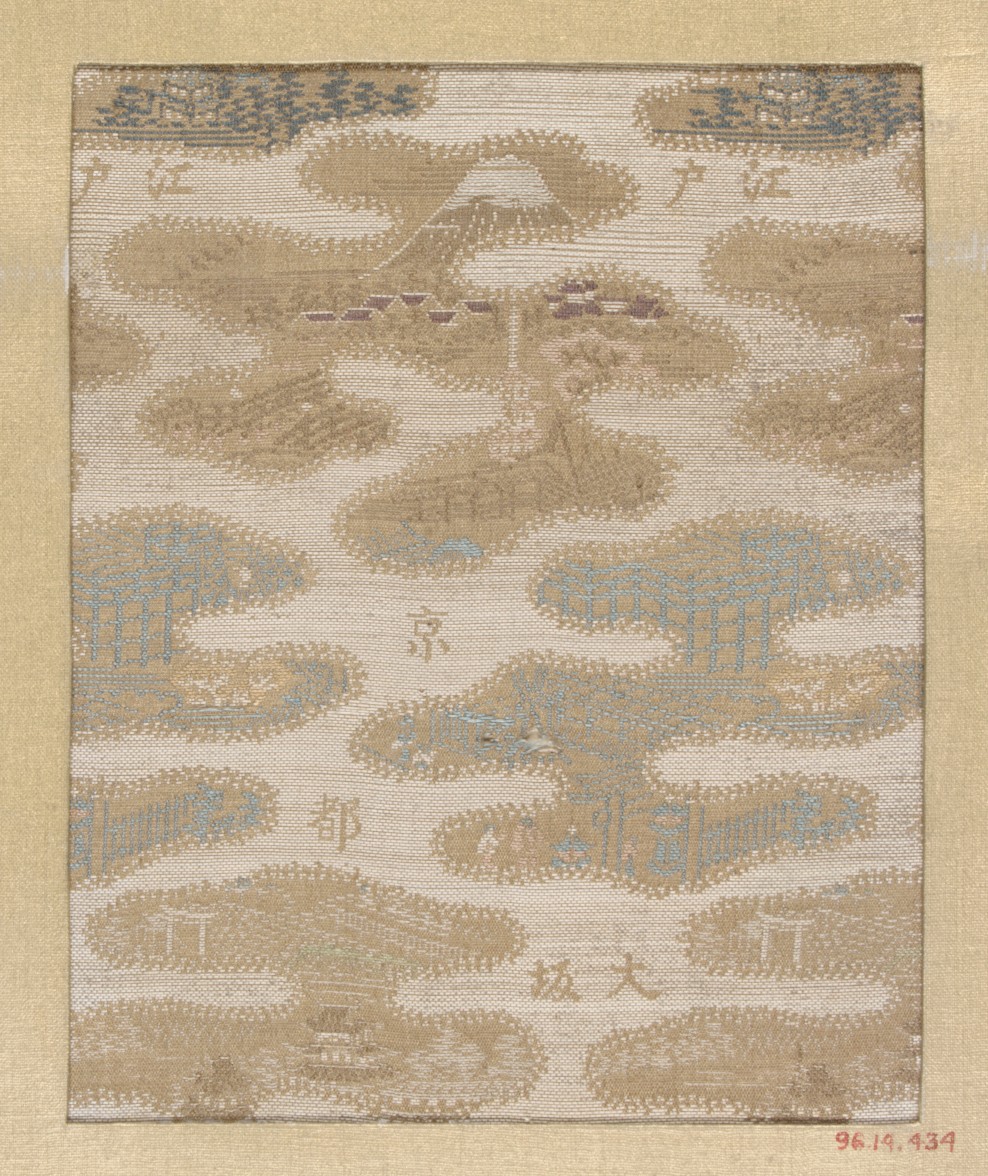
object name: piece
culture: japanese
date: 1701-1900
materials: silk